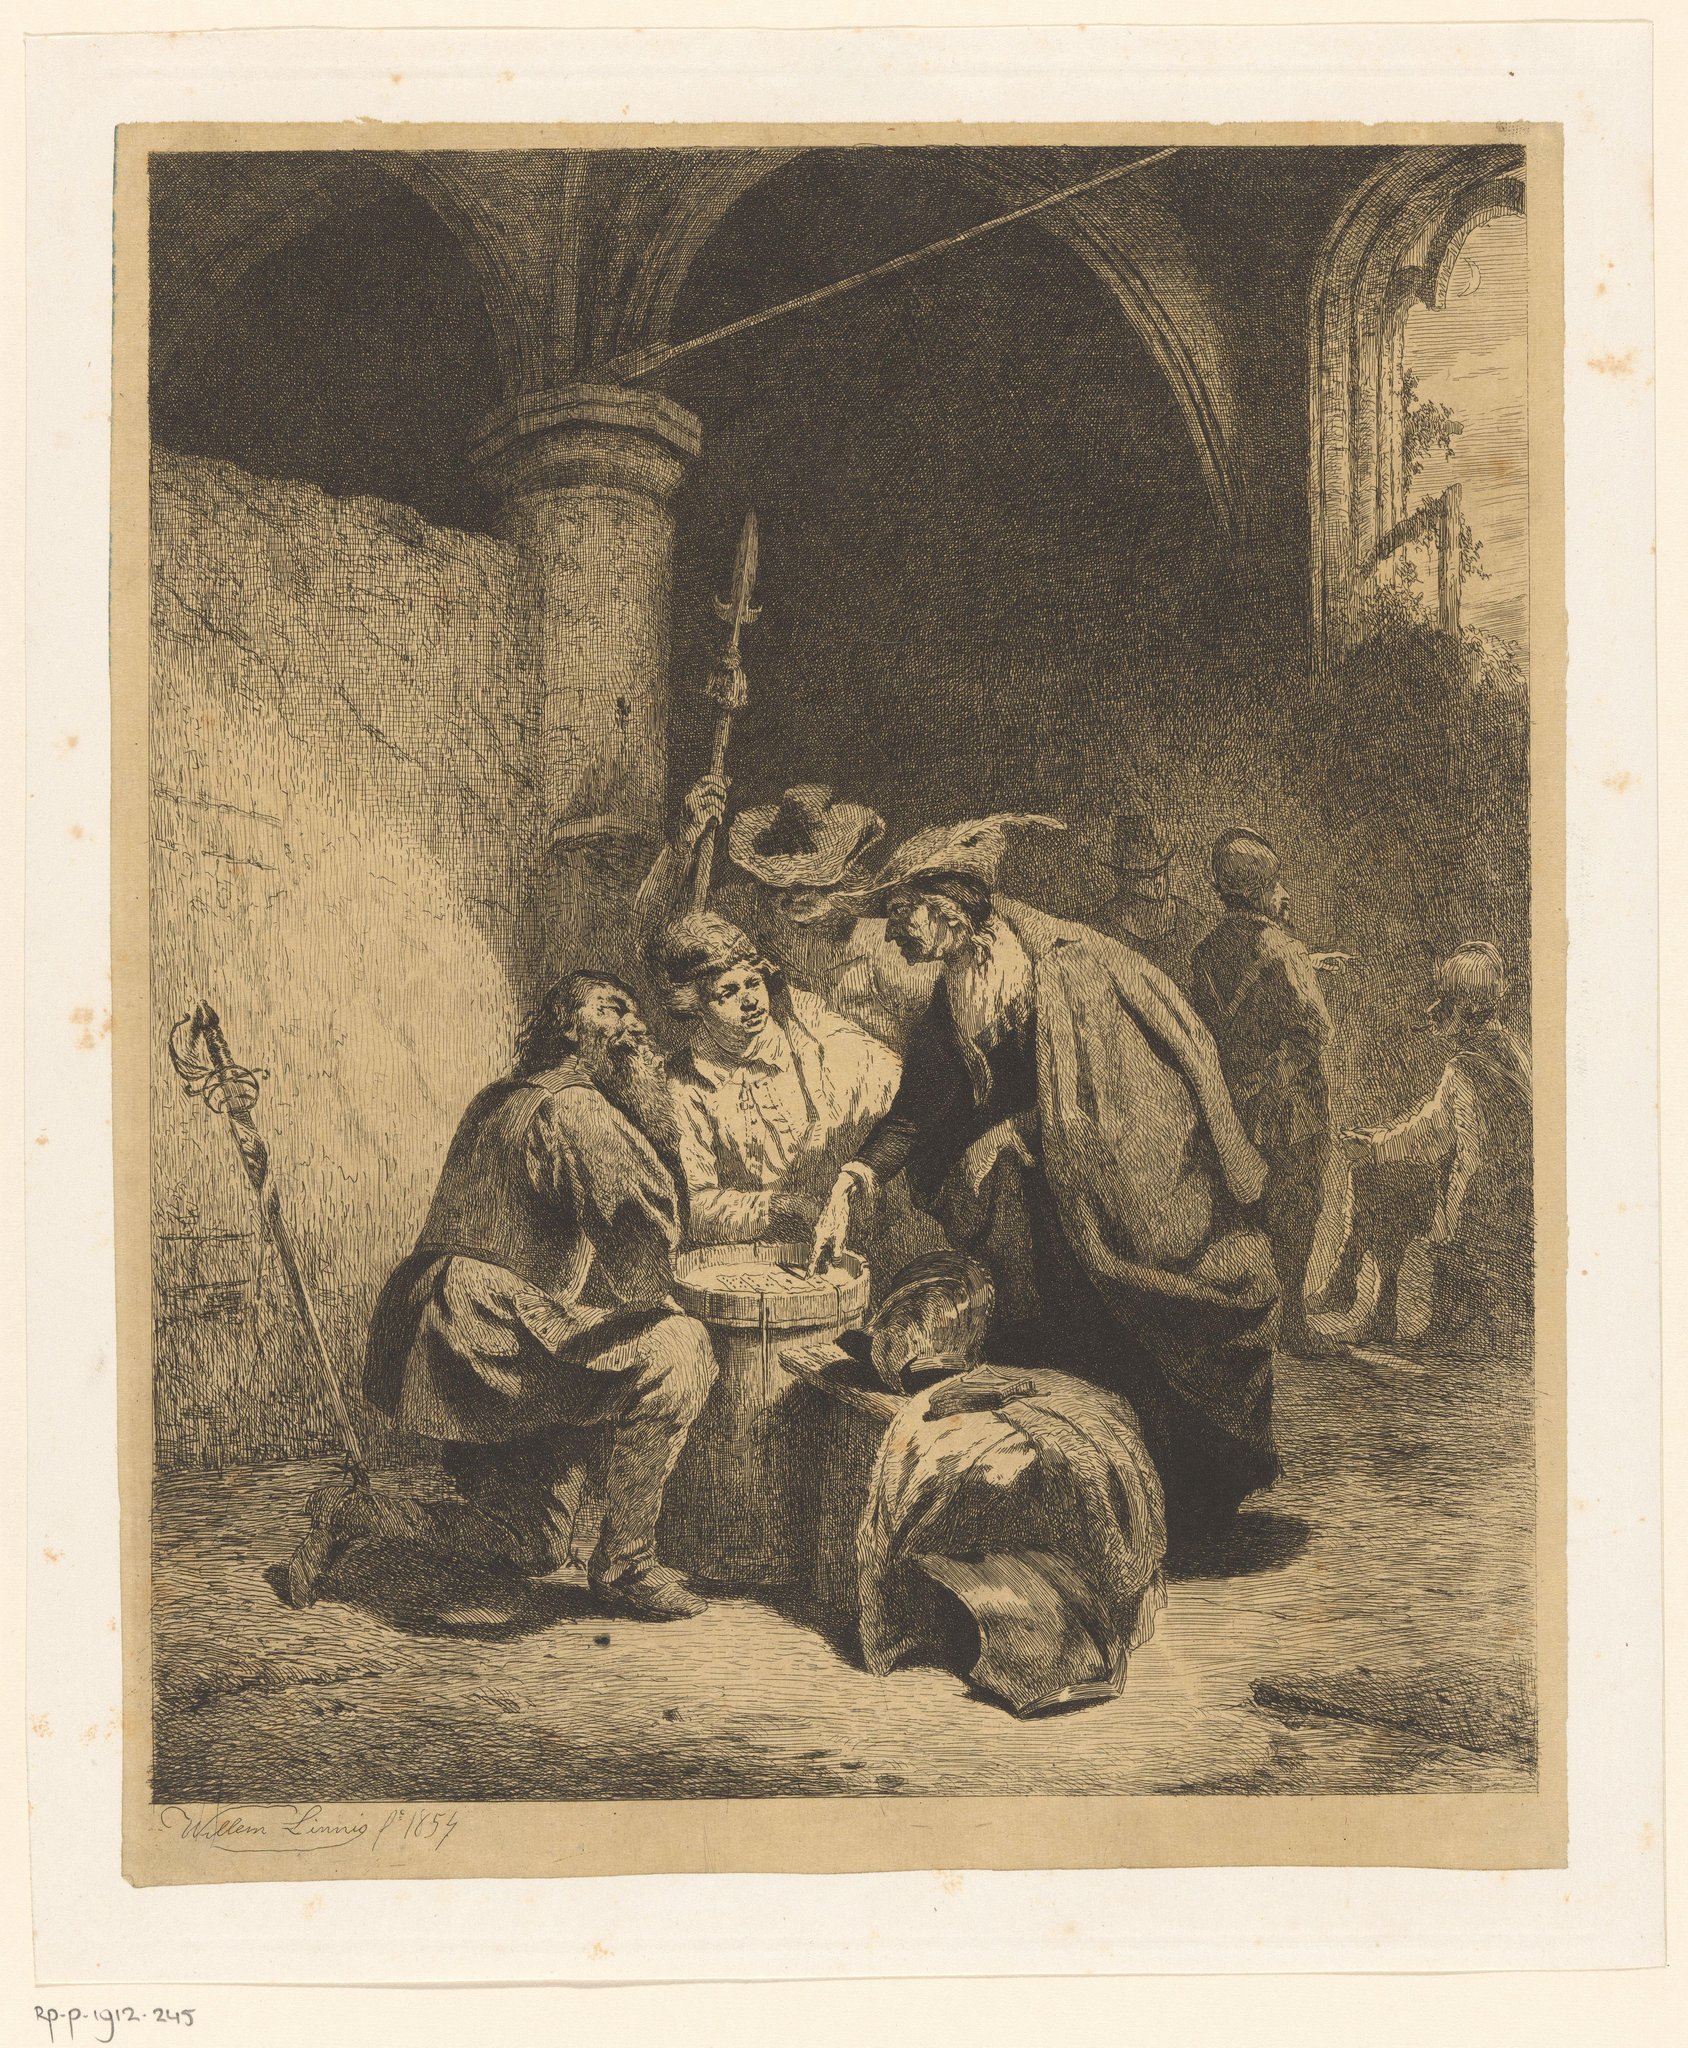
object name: print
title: Kaartspelende soldaten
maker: willem linnig (i)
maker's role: print maker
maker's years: 1819-1885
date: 1857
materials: paper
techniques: etching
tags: drum (musical instrument), playing-cards, guard duty, keeping sentry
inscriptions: collector's mark: Lugt 2228, collector's mark: Lugt 1485